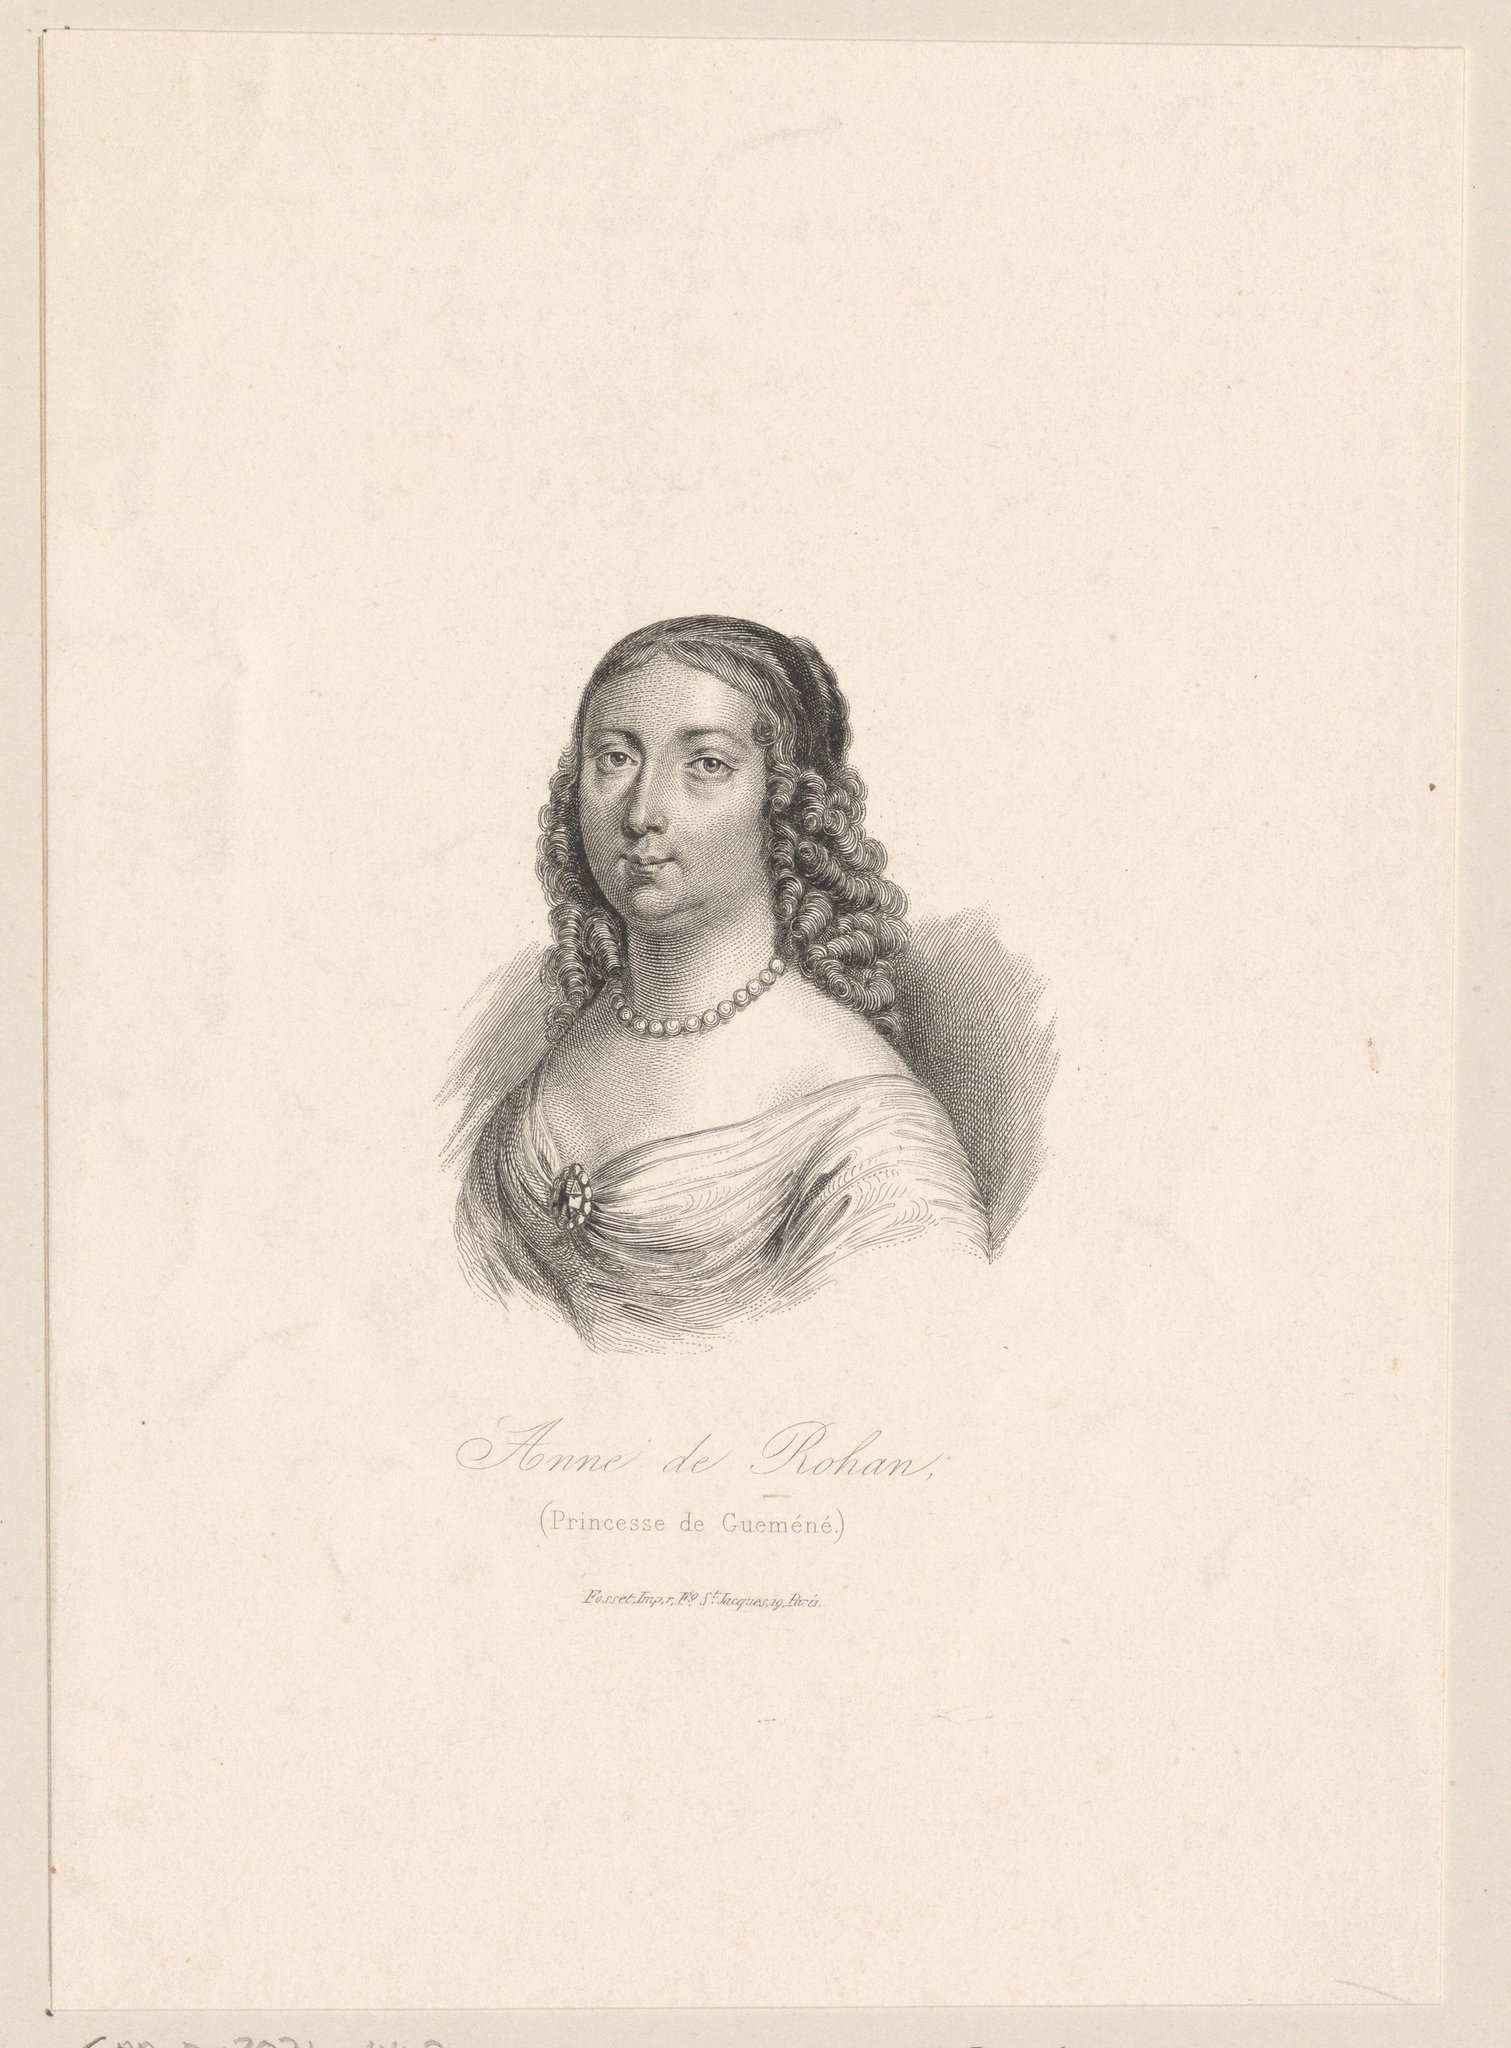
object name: print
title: Portret van Anne de Rohan-Guéméné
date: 1800-1900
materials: paper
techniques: engraving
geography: paris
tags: historical persons